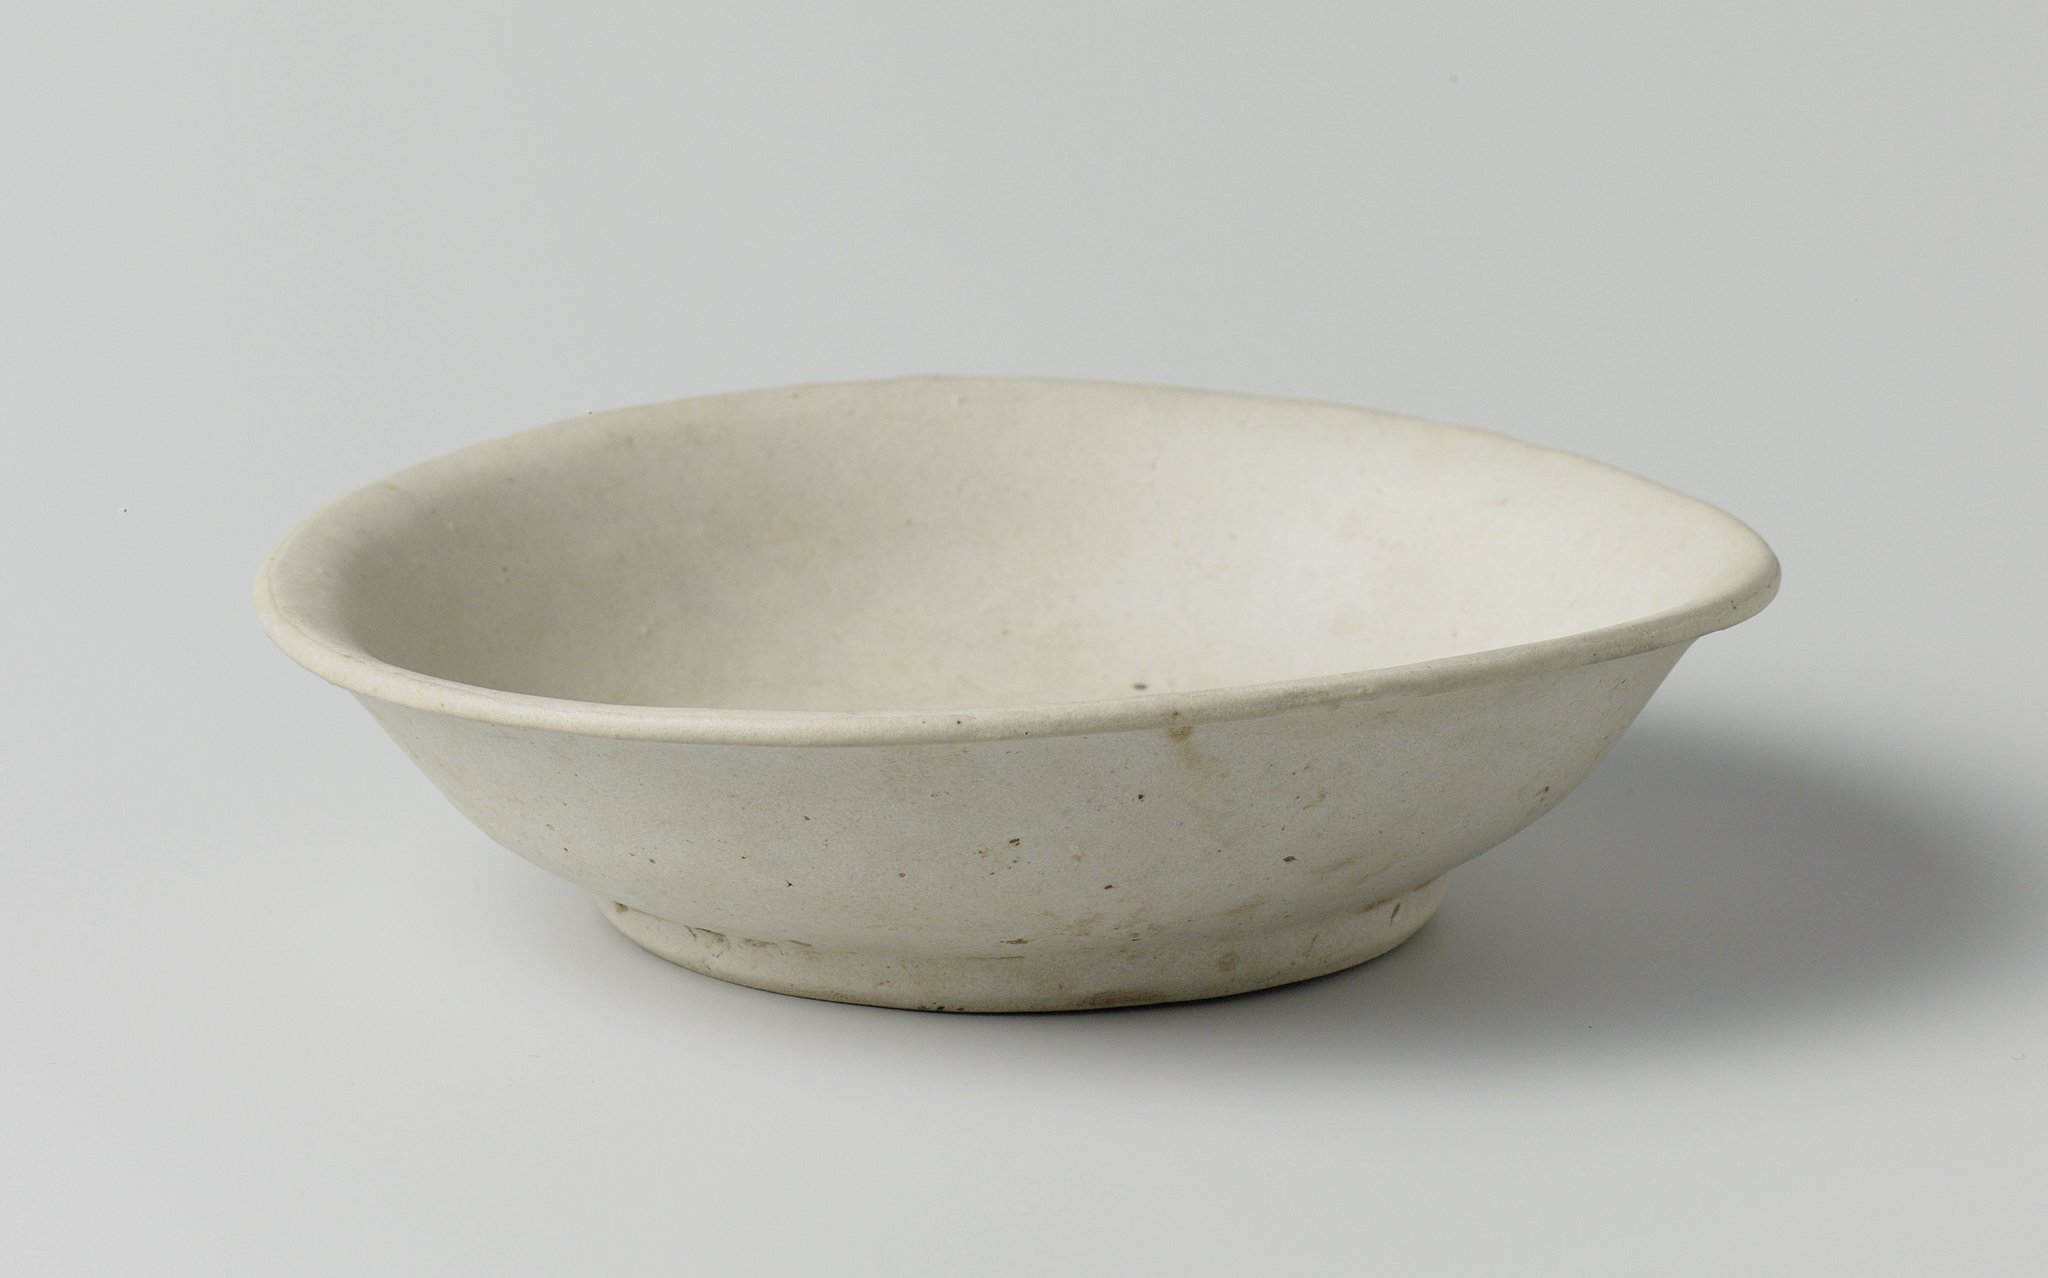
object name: dish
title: Saucer-dish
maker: Anonymous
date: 1600-1699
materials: glaze, porcelain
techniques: firing, turning, vitrification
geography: china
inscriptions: mark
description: Schaal van porselein, bedekt met een gecorrodeerd glazuur. Op de onderzijde een ongeïdentificeerd zegelmerk.